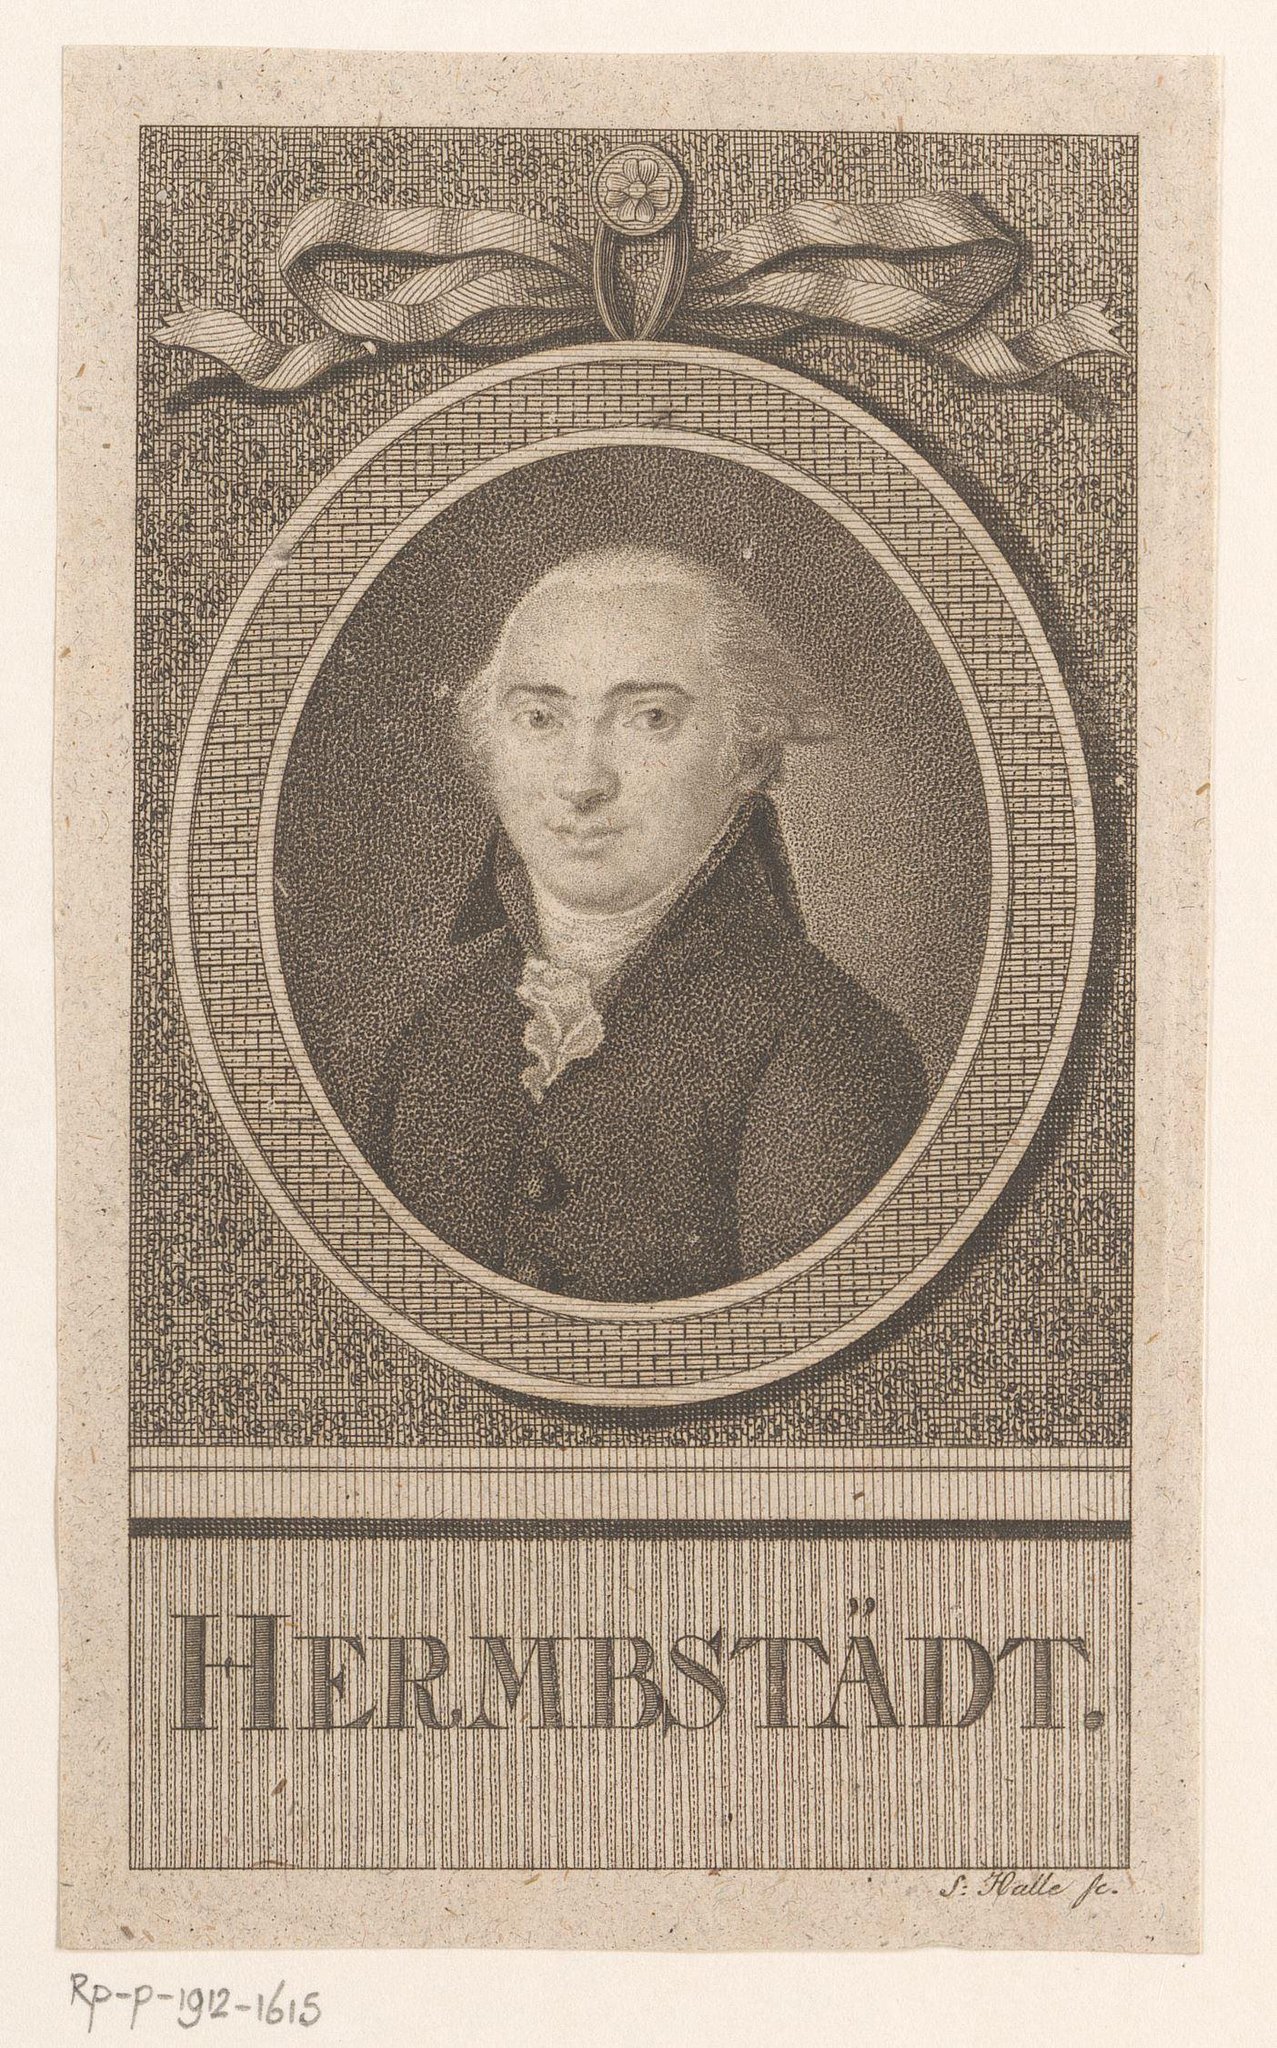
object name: print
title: Portret van Sigismund Friedrich Hermbstaedt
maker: johann samuel ludwig halle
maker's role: print maker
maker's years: 1763-1829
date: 1770-1833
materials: paper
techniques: engraving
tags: berlin, sigismund friedrich hermbstaedt, pharmacist, druggist, apothecary; pharmacy, drugstore, dispensing chemist, ornament ~ medallion (+ framing decorations), historical persons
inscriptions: collector's mark: Lugt 2228